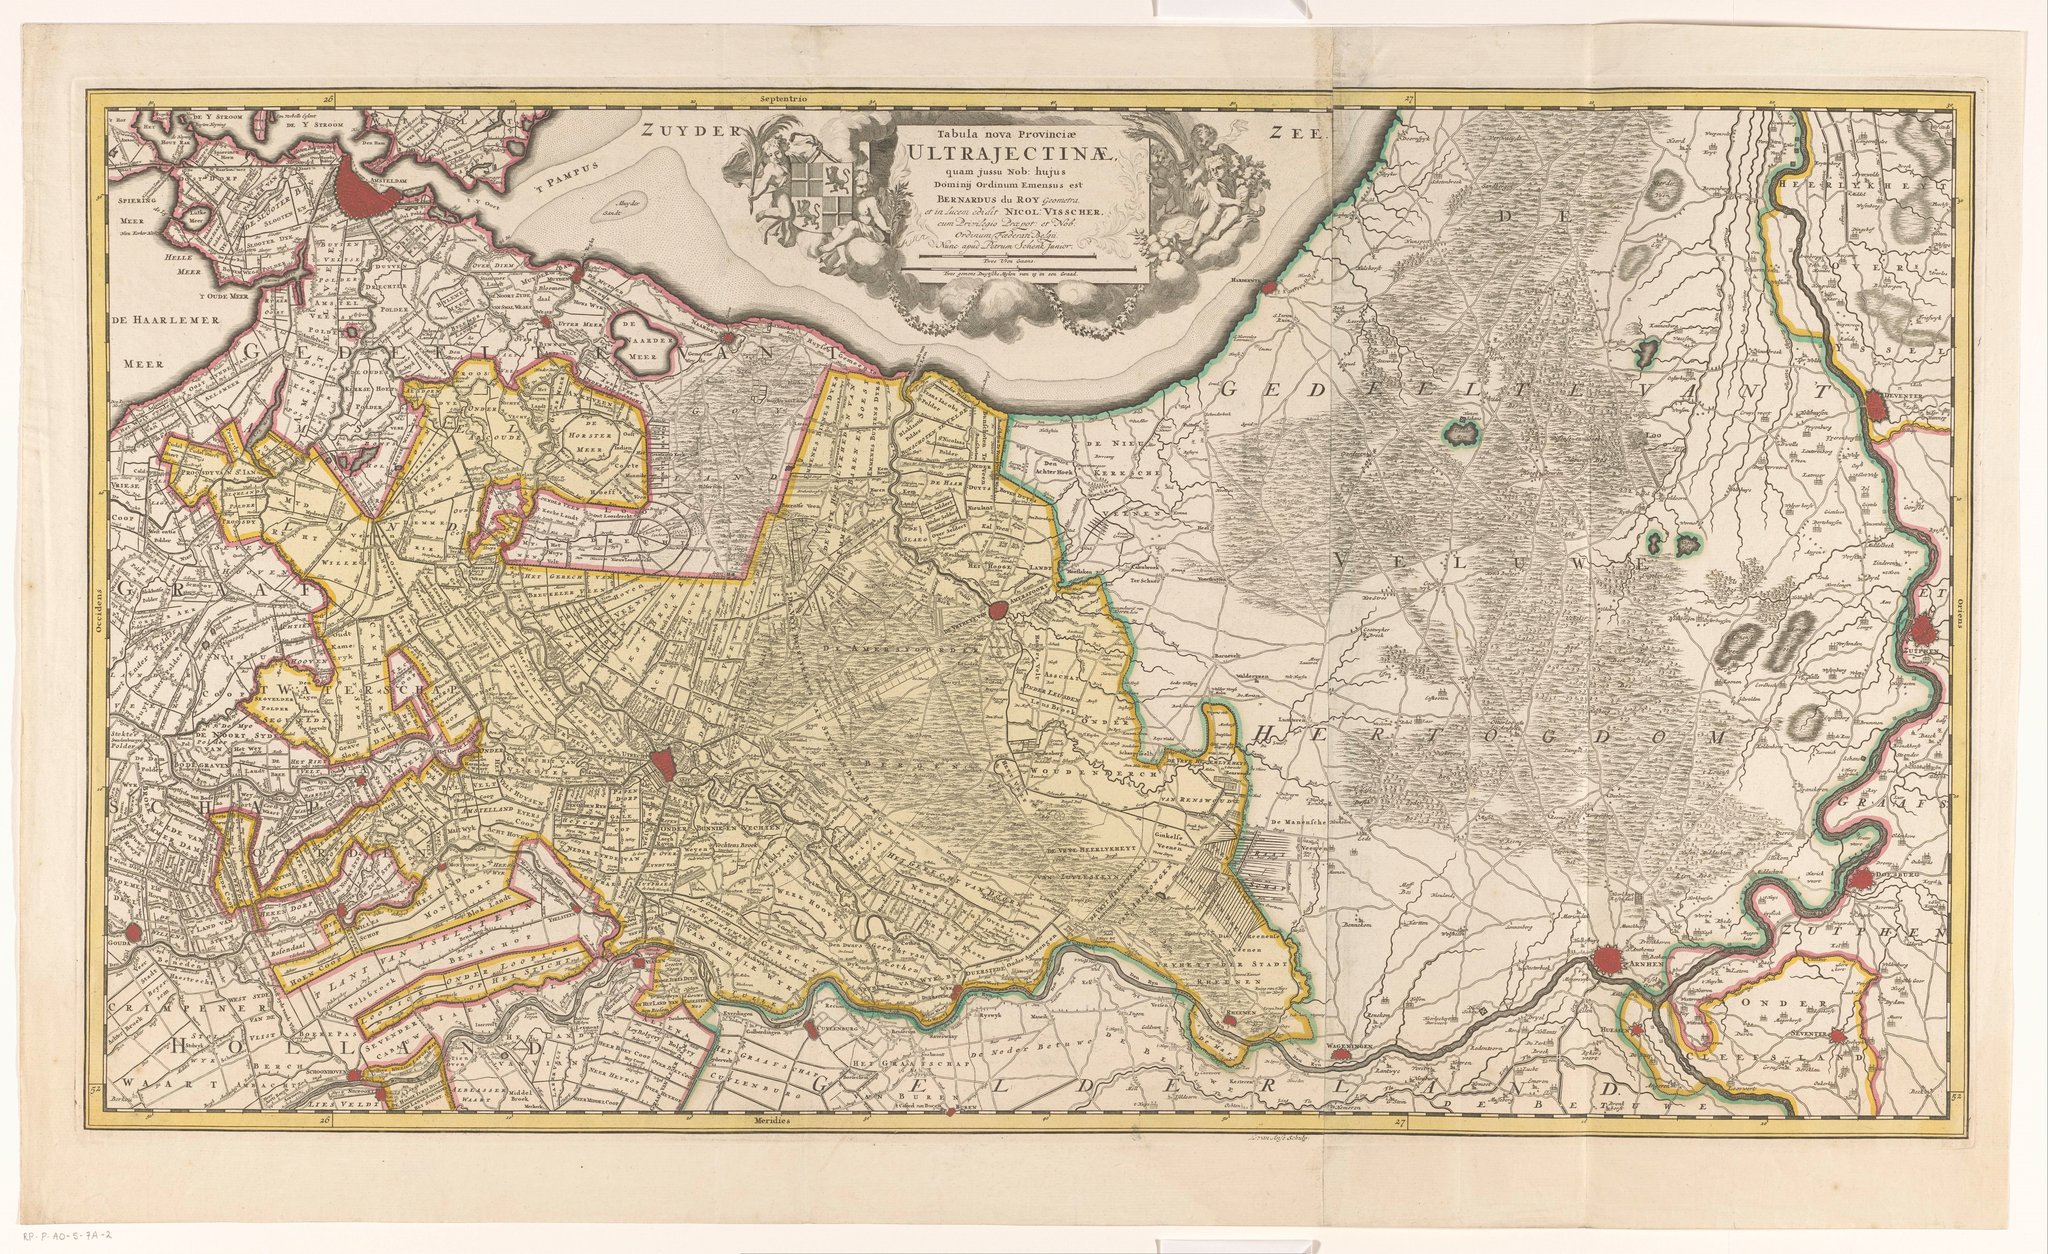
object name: map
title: Tabula nova provinciae Ultrajectinae …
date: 1679-1682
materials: paper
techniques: engraving, etching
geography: amsterdam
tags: coat of arms (as symbol of the state, etc.), maps of separate countries or regions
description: Boven in het midden een cartouche met de titel en twee schaalstokken: Twee uren gaans; Twee gemene Duytsche mylen van 15 in een graad. Daaromheen het wapen van de provincie Utrecht en putti. Gradenverdeling langs de randen.